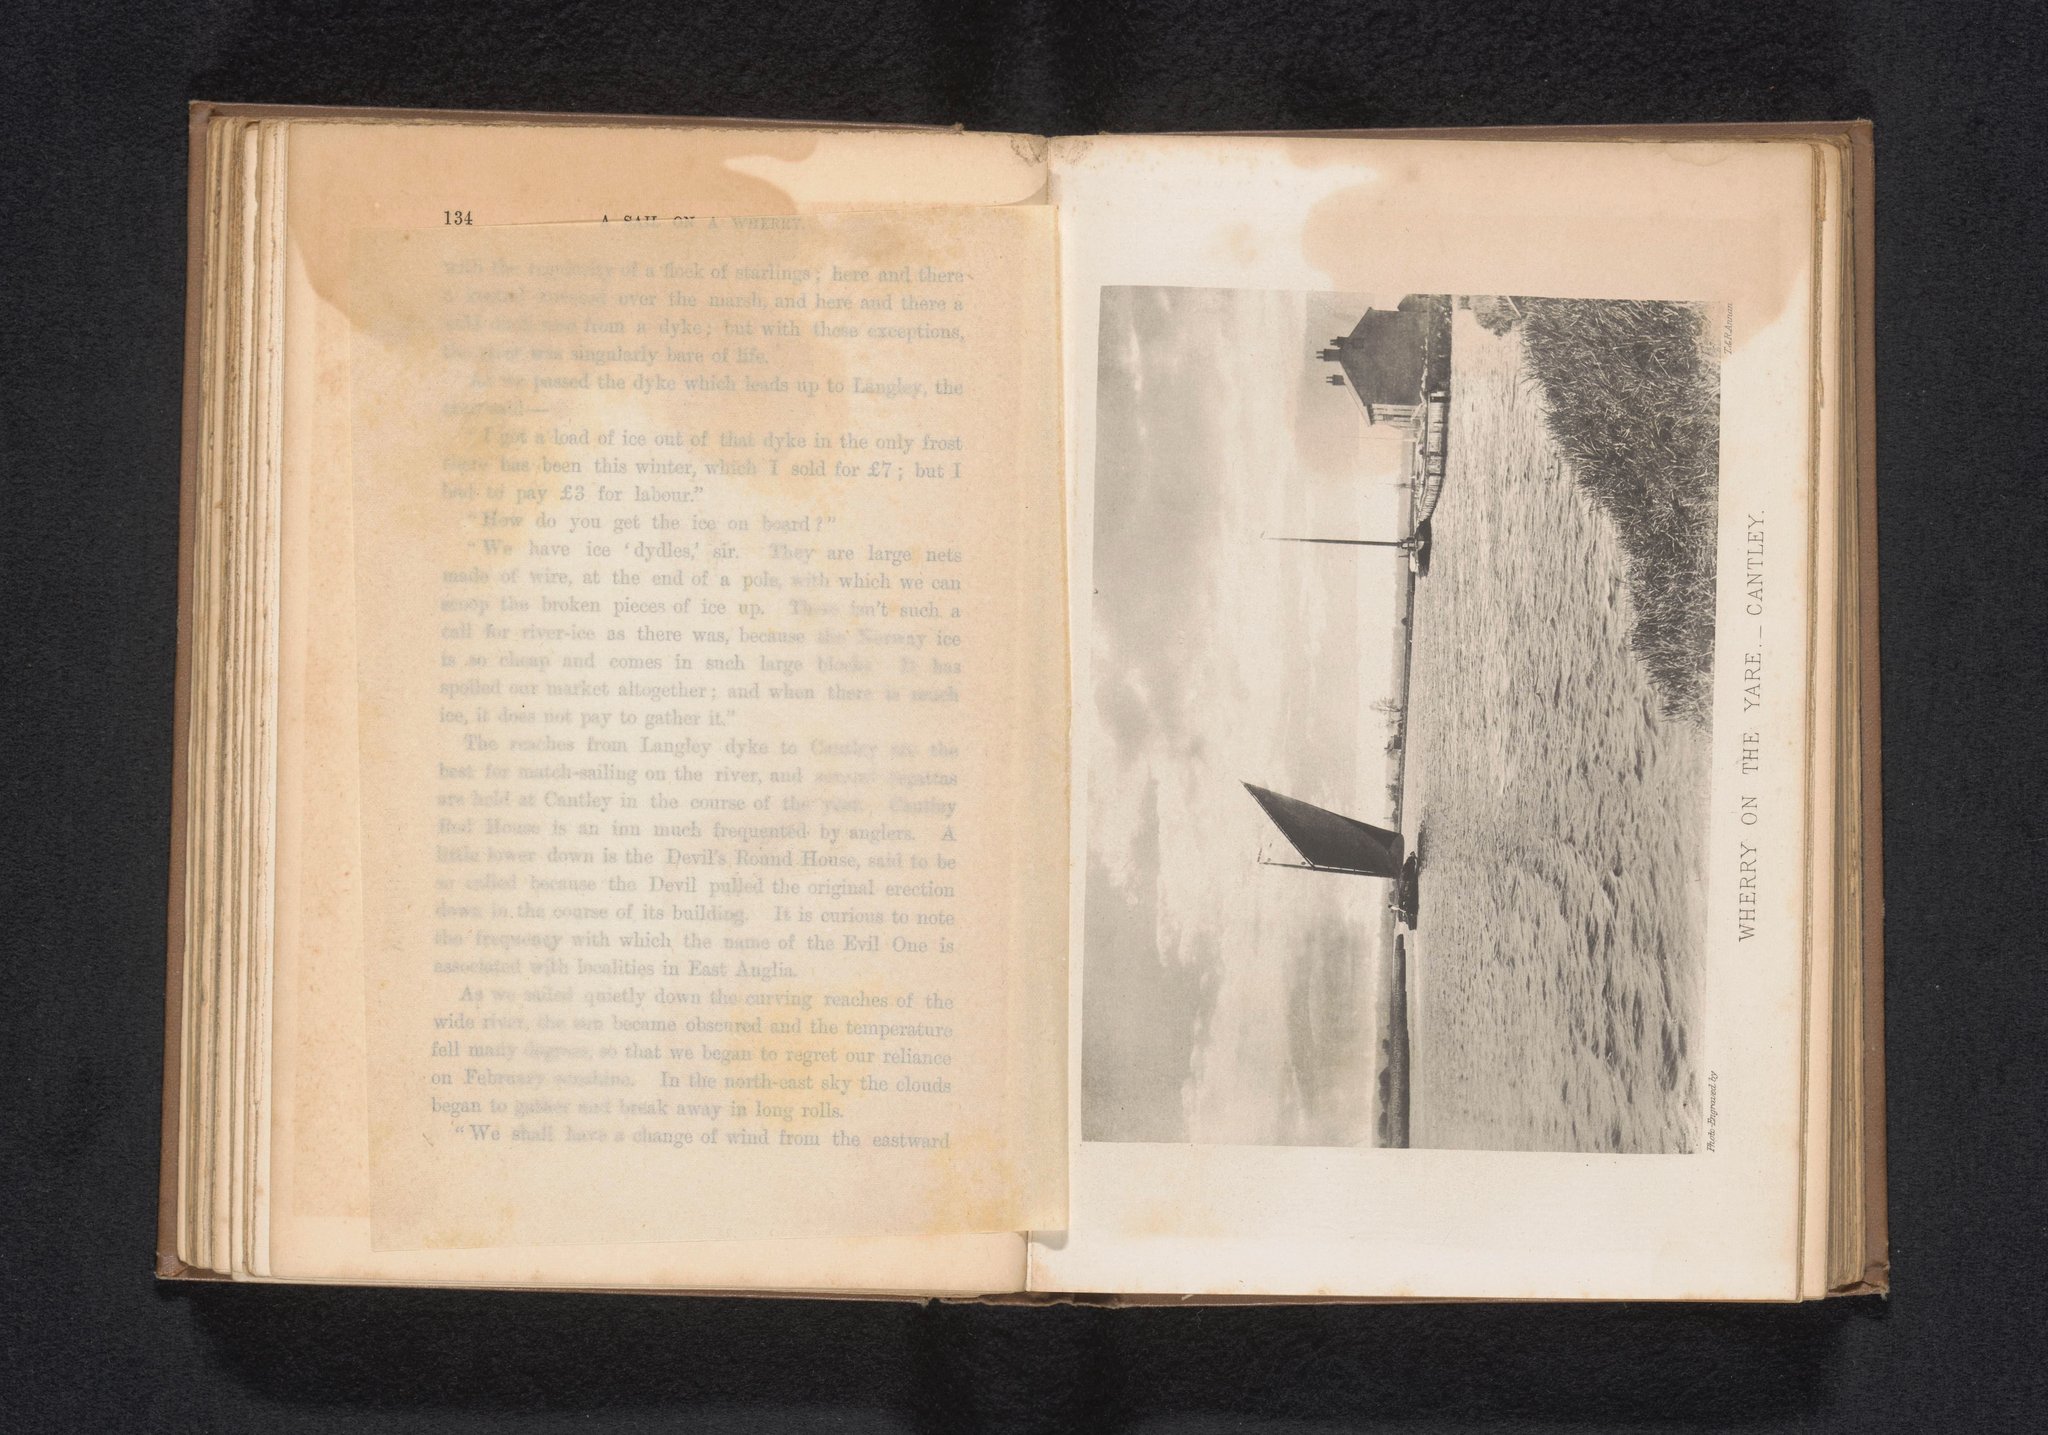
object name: photomechanical print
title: Wherry on the Yare, Cantley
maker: george christopher davies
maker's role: fotograaf, geoloog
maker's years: 1849-1922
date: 1878-1883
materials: paper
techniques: photoaquatint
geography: cantley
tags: sailing-ship, sailing-boat, river